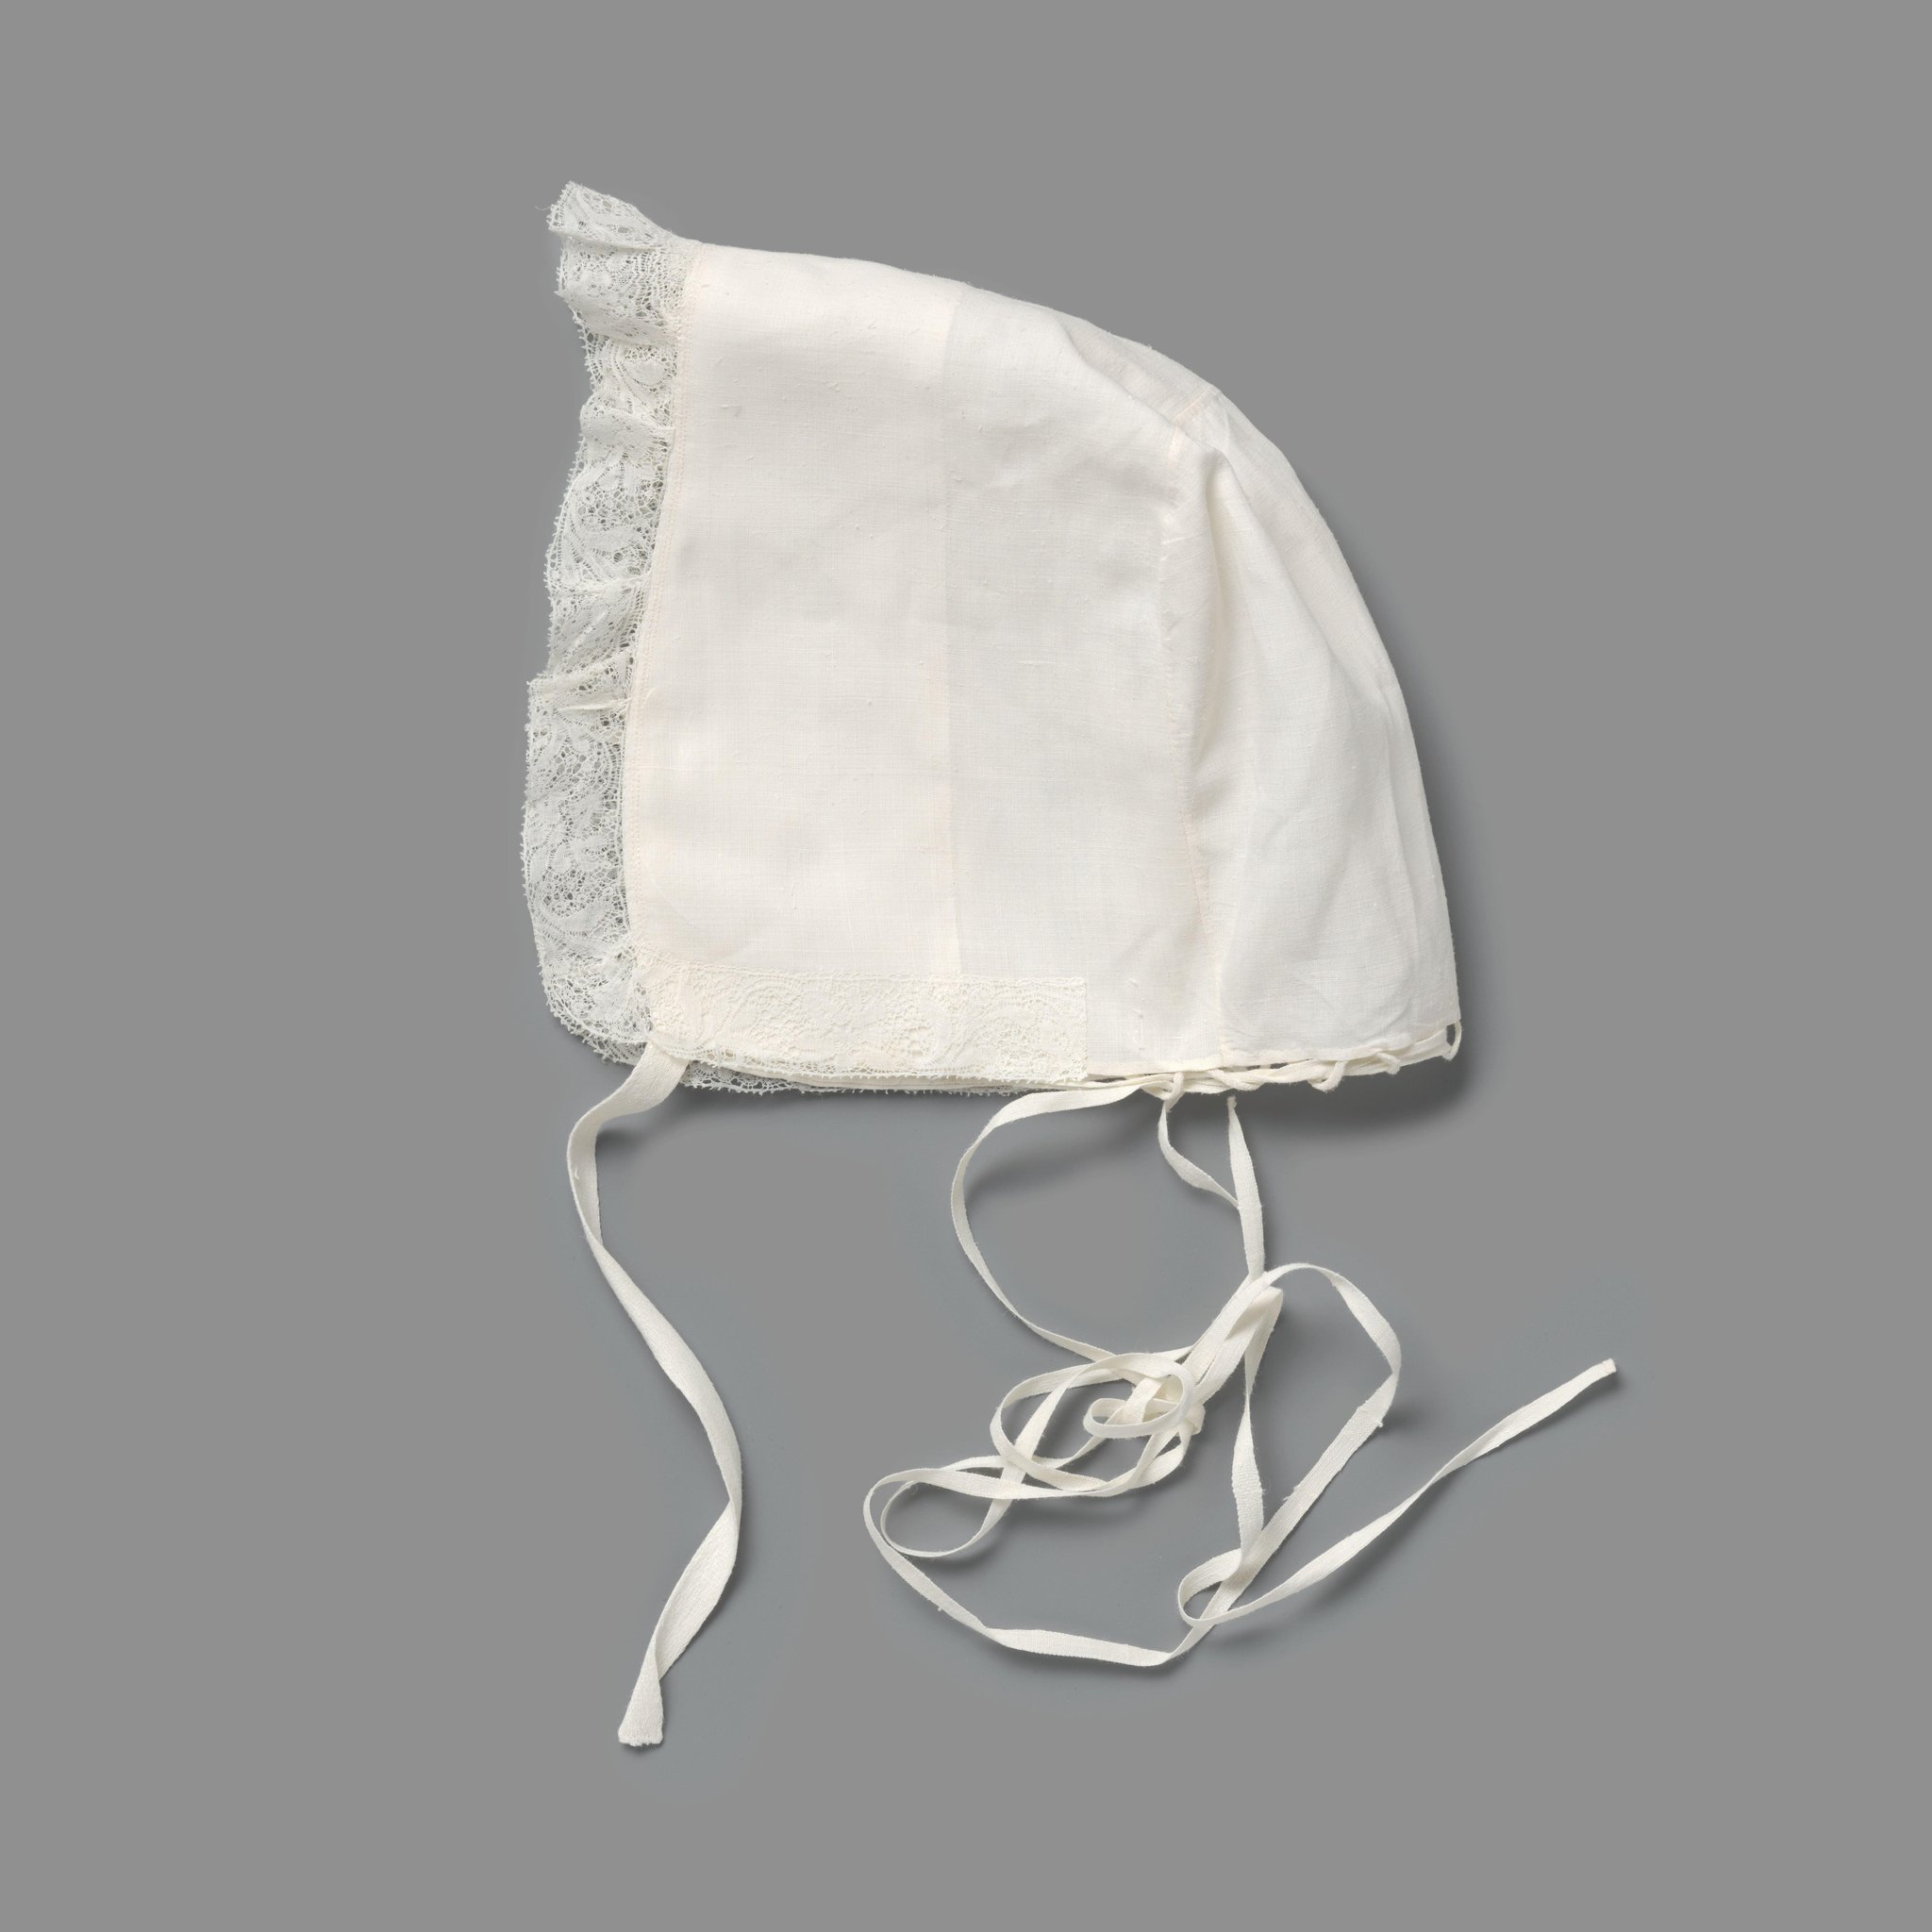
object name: cap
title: Kindermuts van linnen met Binchekant; gemerkt: S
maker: Anonymous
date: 1740-1760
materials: linen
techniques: lace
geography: netherlands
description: Een kindermuts van linnen en Binchekant. in drie maten en gemerkt S. Model. Handgenaaid. Brede voorpas met de zoom tot op het midden daarvan. Hoefijzervormige bol. Aangenaalde vetertjes vormen busjes voor het achterste bantje. Slechts met één kinnebandje, dat terzijde wordt gespeld. b. Kant. Binchekant met rechte picotrand, spinnenfond en slingerende rank met trosjes. Ook verbreed in midden.